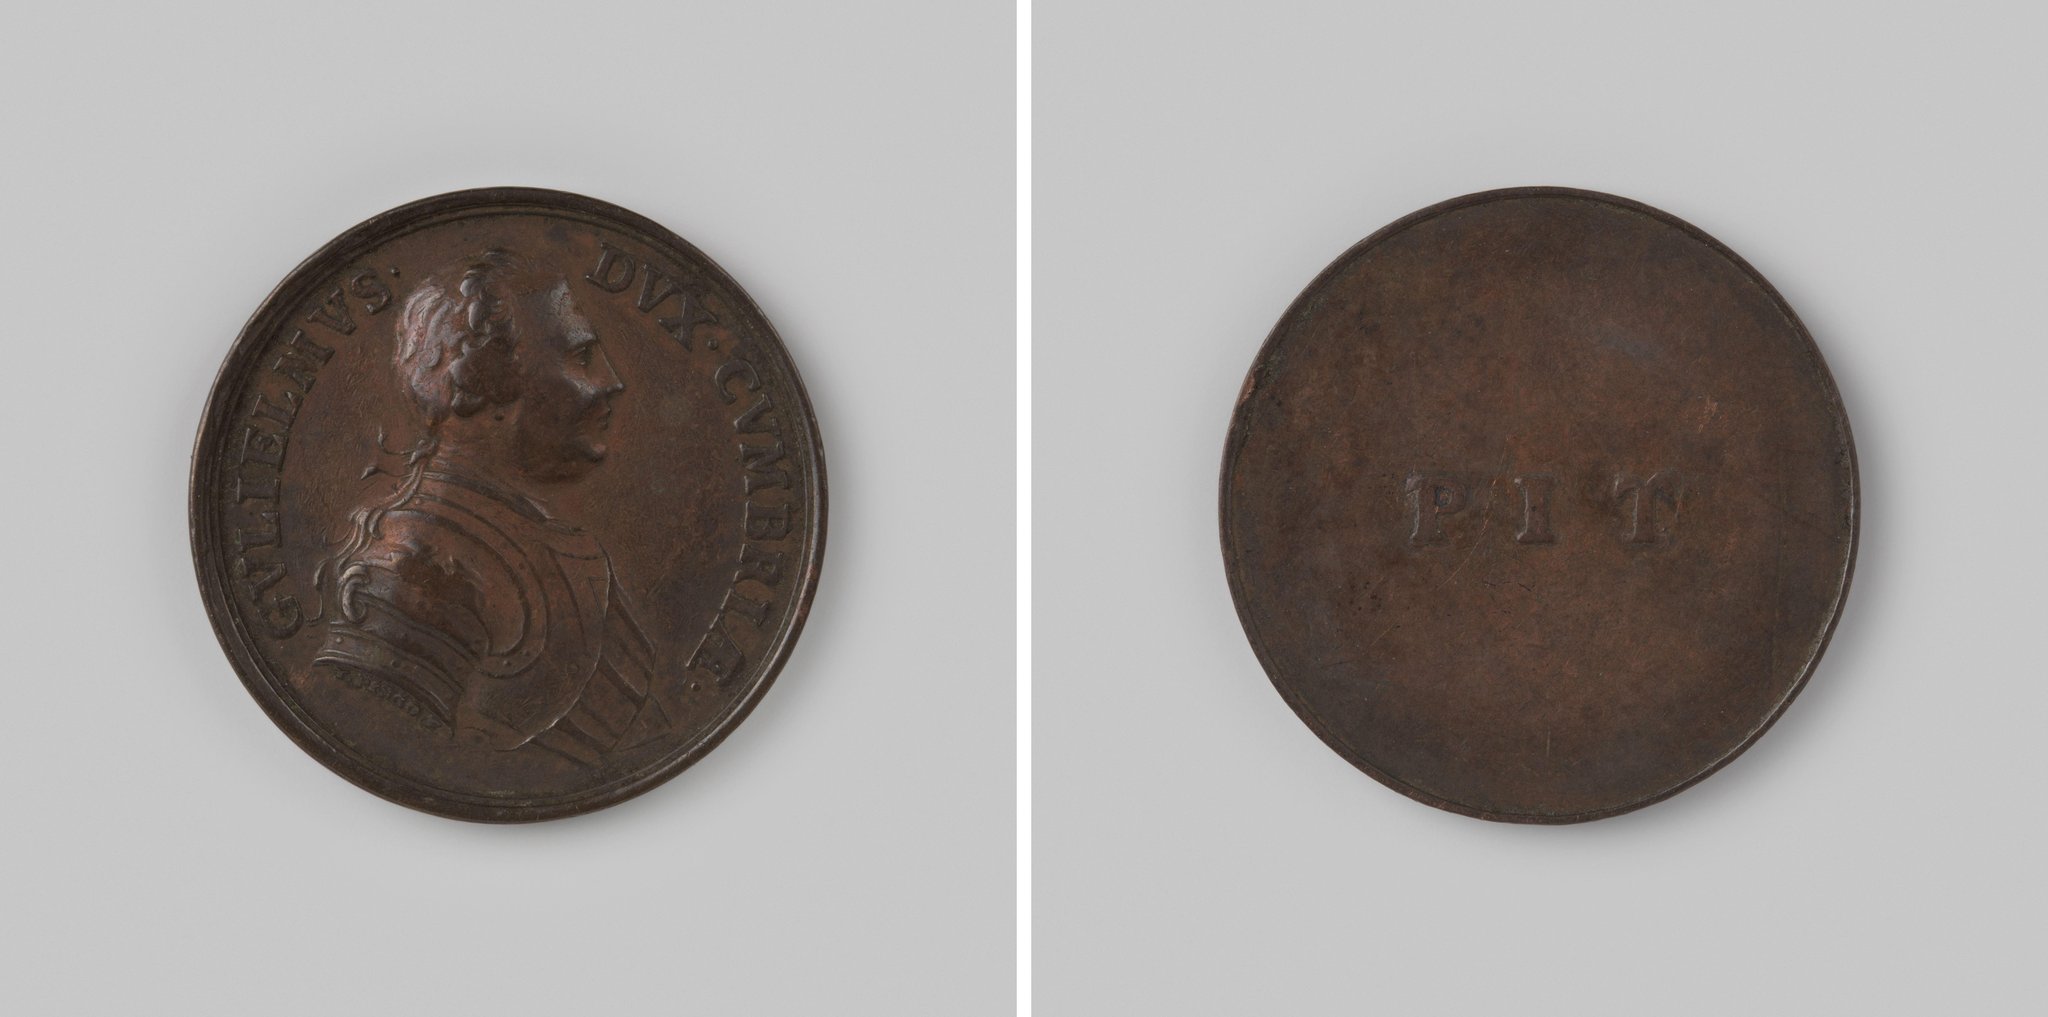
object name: history medal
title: Willem, hertog van Cumberland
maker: thomas pingo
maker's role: medailleur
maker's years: 1692-1776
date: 1765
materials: bronze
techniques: striking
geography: london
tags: prins, admiraal, willem van cumberland (hertog)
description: Bronzen penning. Voorzijde: borststuk man binnen omschrift. Keerzijde: omschrift